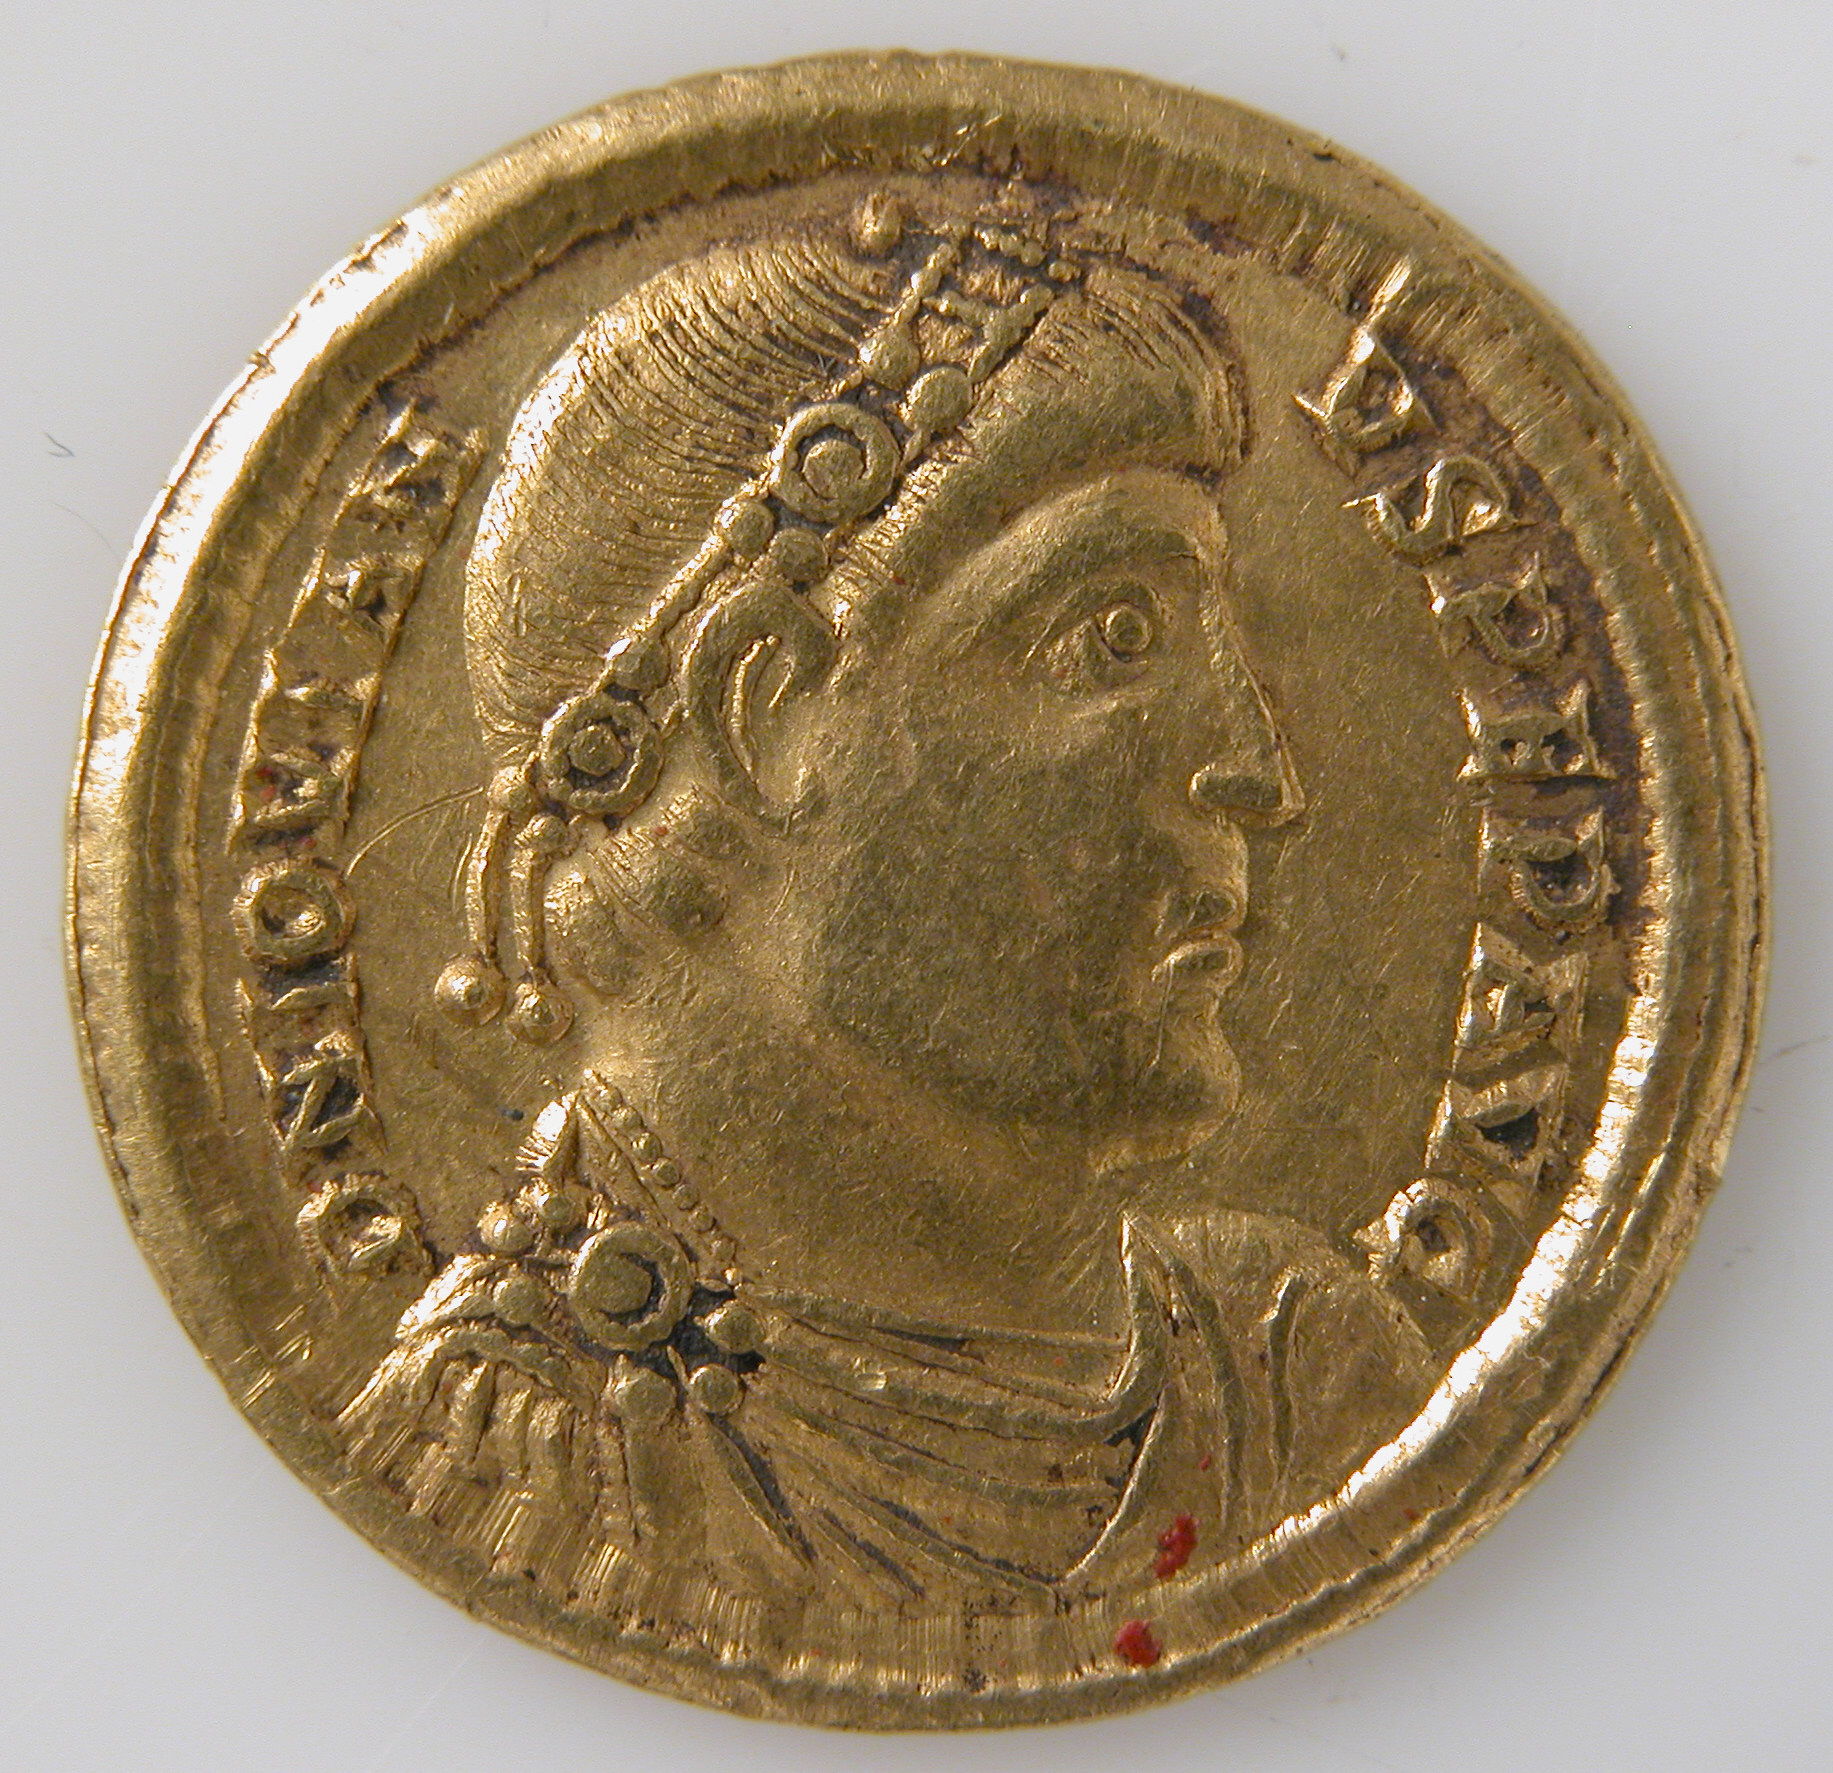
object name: solidus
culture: byzantine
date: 363-364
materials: gold